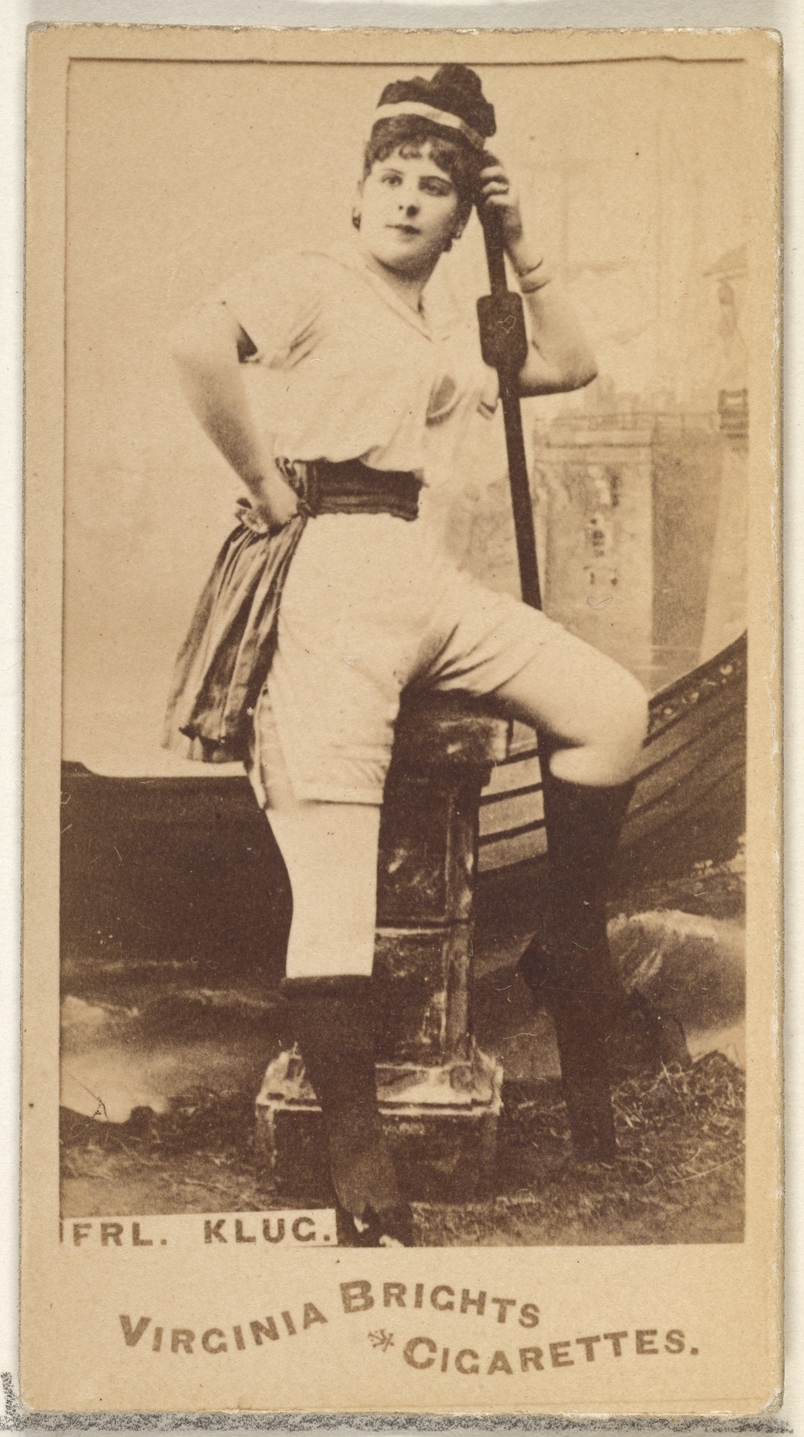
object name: photograph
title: Fräulein Klug, from the Actors and Actresses series (N45, Type 1) for Virginia Brights Cigarettes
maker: allen & ginter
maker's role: publisher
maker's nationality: american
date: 1888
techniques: albumen silver print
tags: portraits,women,actresses